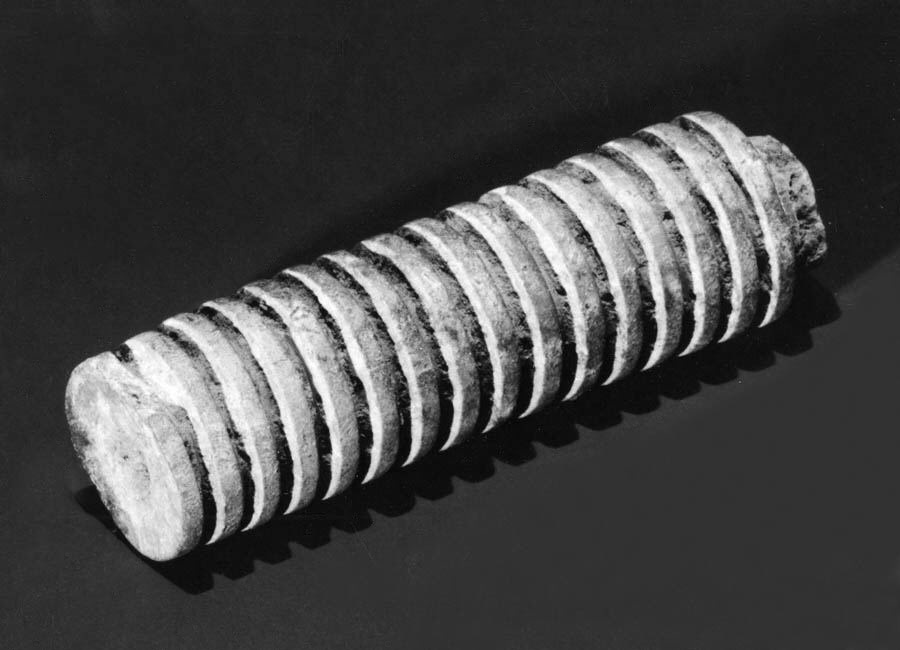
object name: paint roller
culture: thai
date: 3500 BCE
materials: earthenware